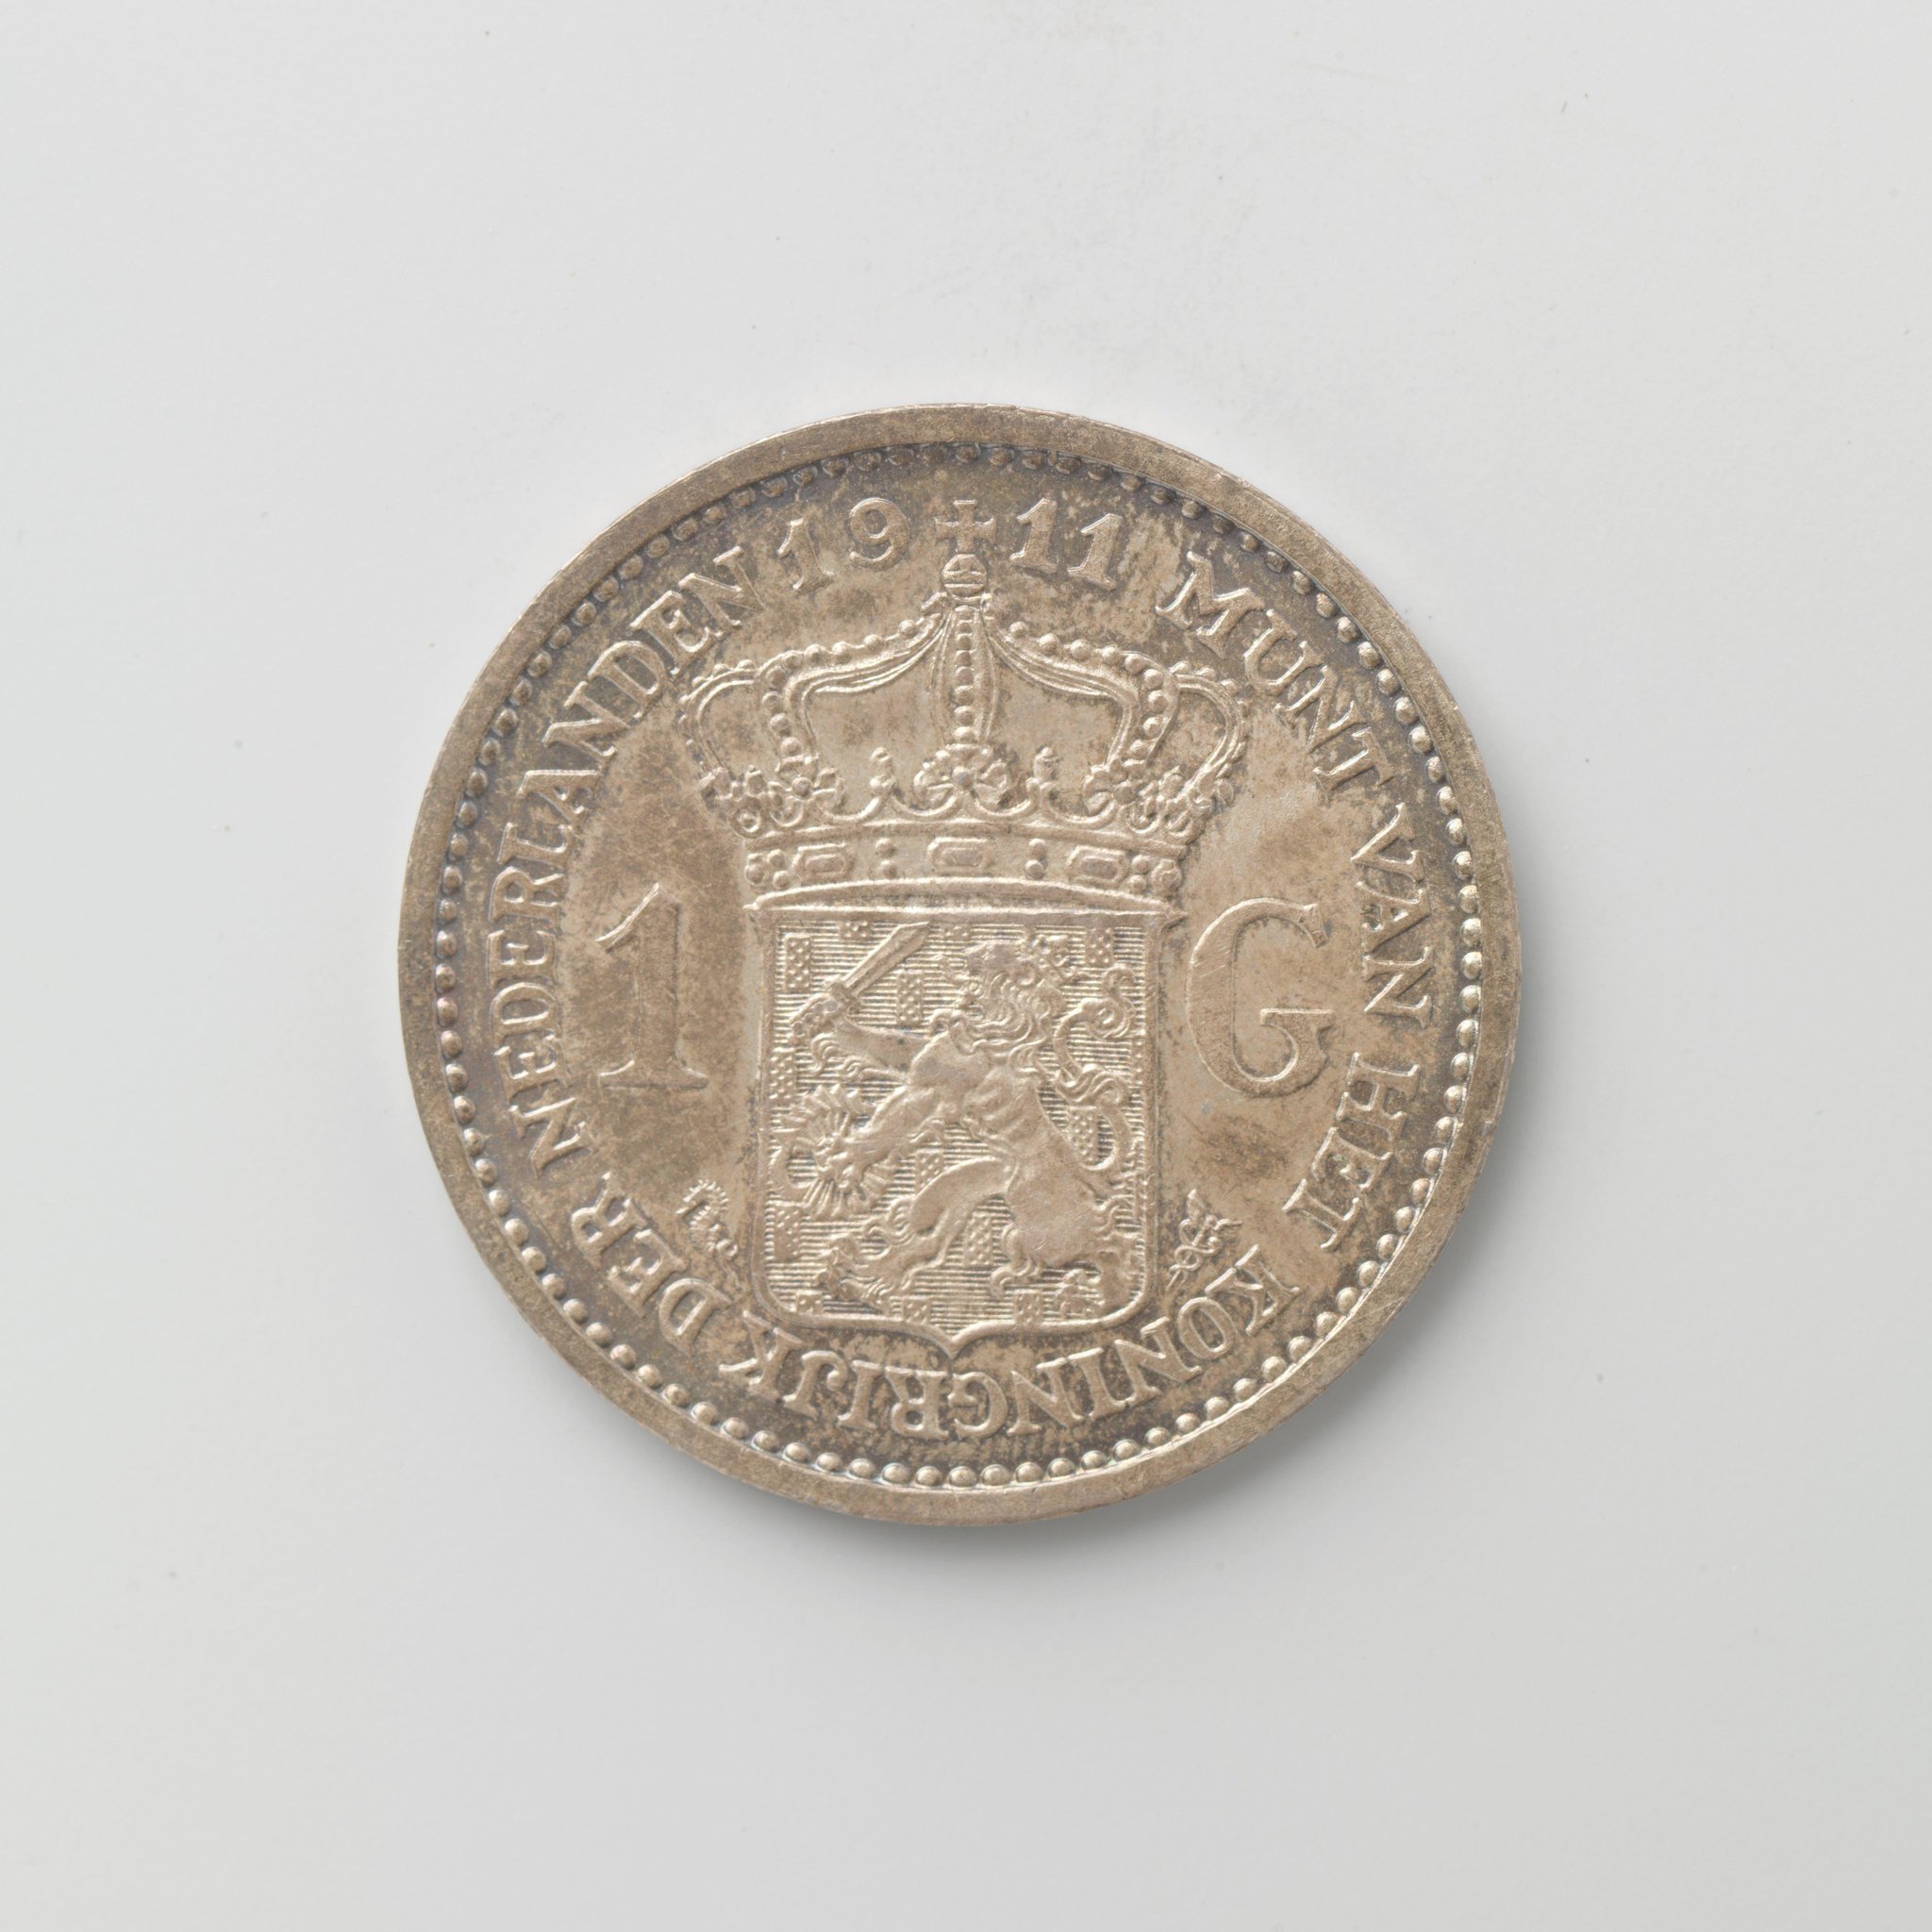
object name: coin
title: Nederlandse gulden,1911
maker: wilhelmina of the netherlands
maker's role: print maker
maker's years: 1880-1962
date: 1911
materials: silver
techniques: striking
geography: utrecht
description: Zilveren munt. Voorzijde: gedrapeerd borstbeeld met diadeem naar links. Keerzijde: tussen waarde-aanduiding 1 G gekroond rijkswapenschild. Jaartal bovenaan in omschrift. Randschrift.